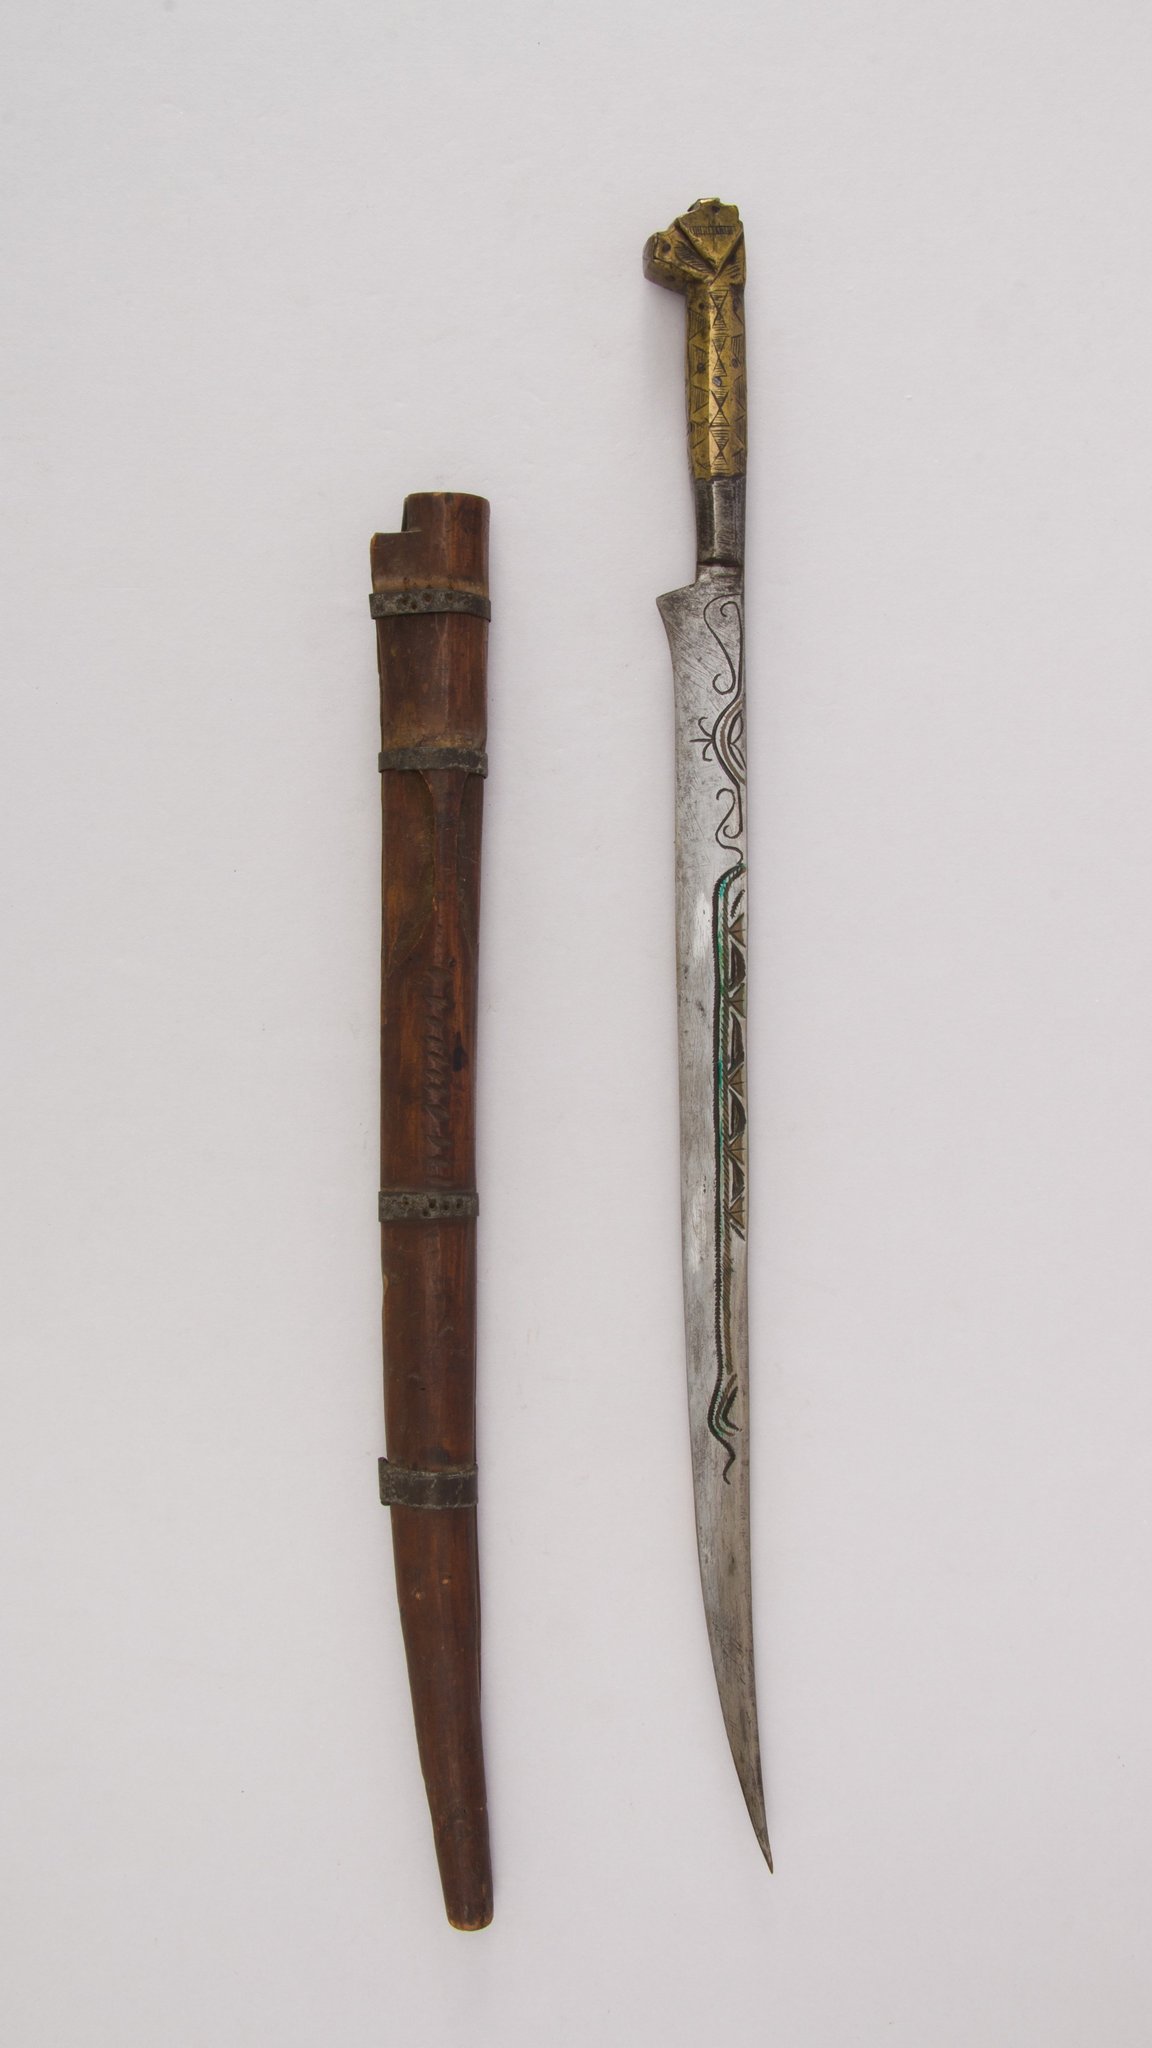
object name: knife flyssa with sheath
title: Knife (Flyssa) with sheath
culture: algerian or kabyle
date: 1801-1900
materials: brass, iron, steel, wood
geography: morocco